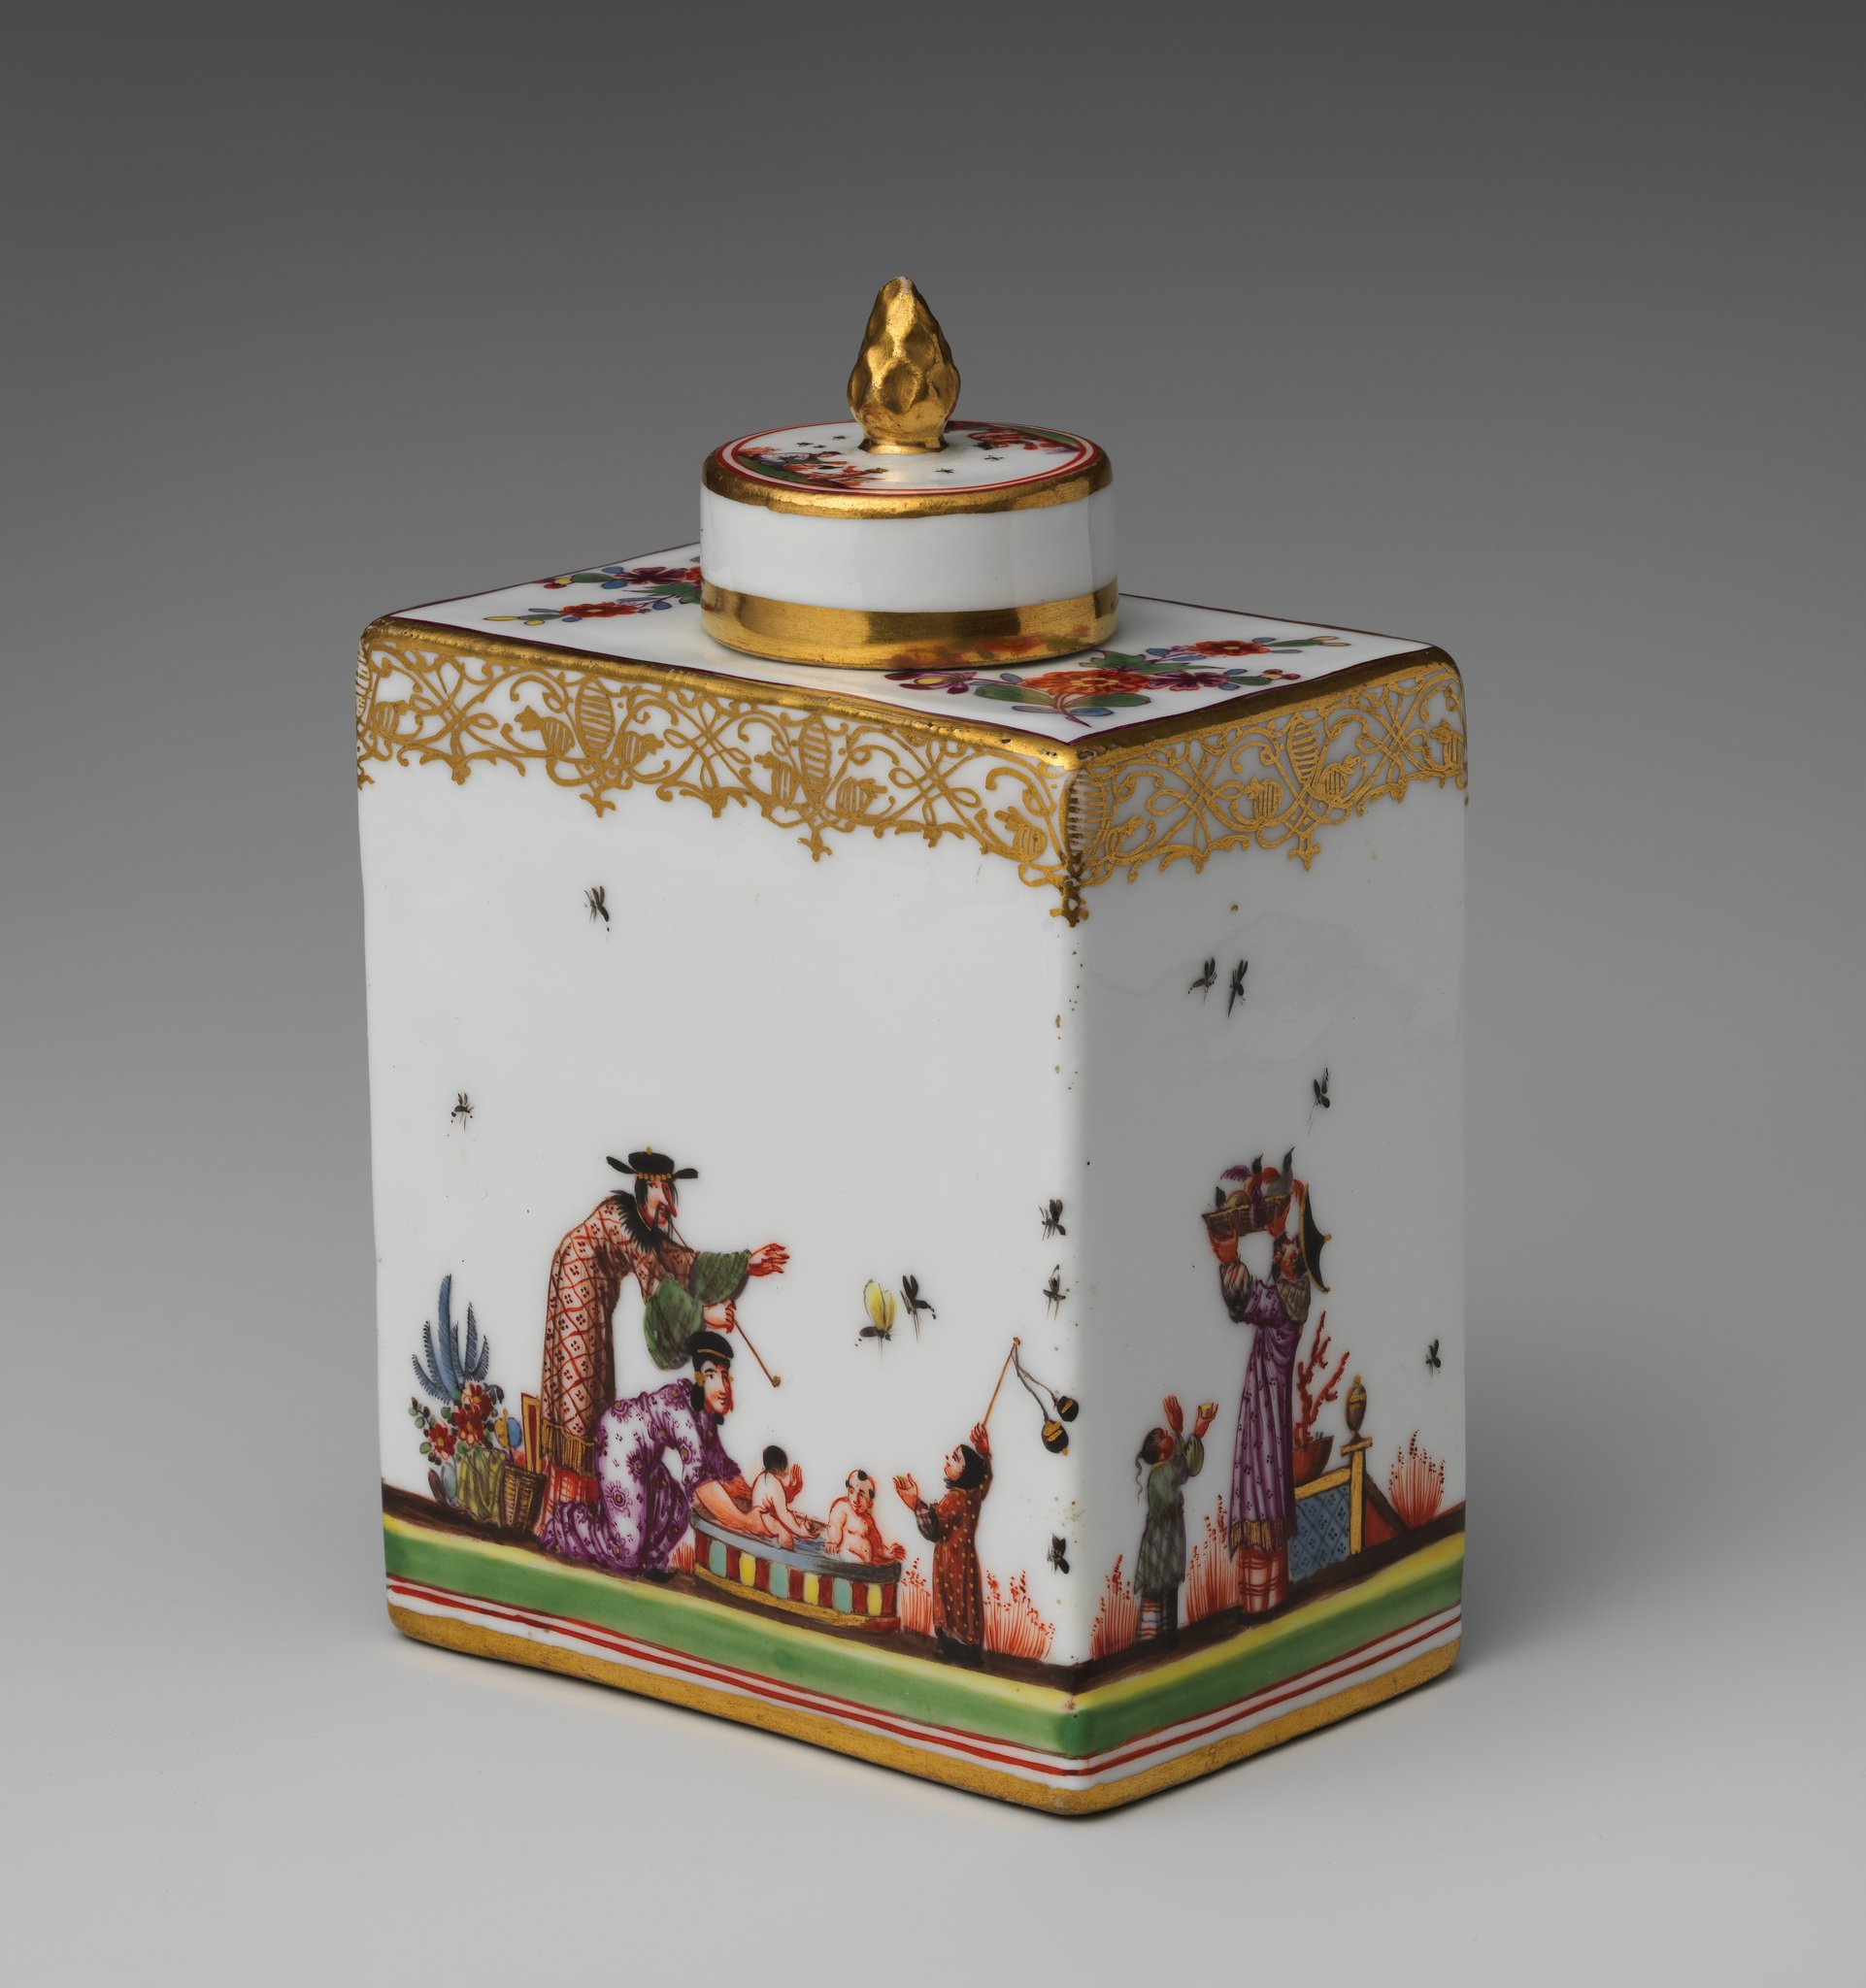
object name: caddy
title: Caddy (part of a set)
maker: meissen manufactory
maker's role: manufactory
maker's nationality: german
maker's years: 1710-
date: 1735-1740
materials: hard paste porcelain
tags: chinoiserie,children,men,insects